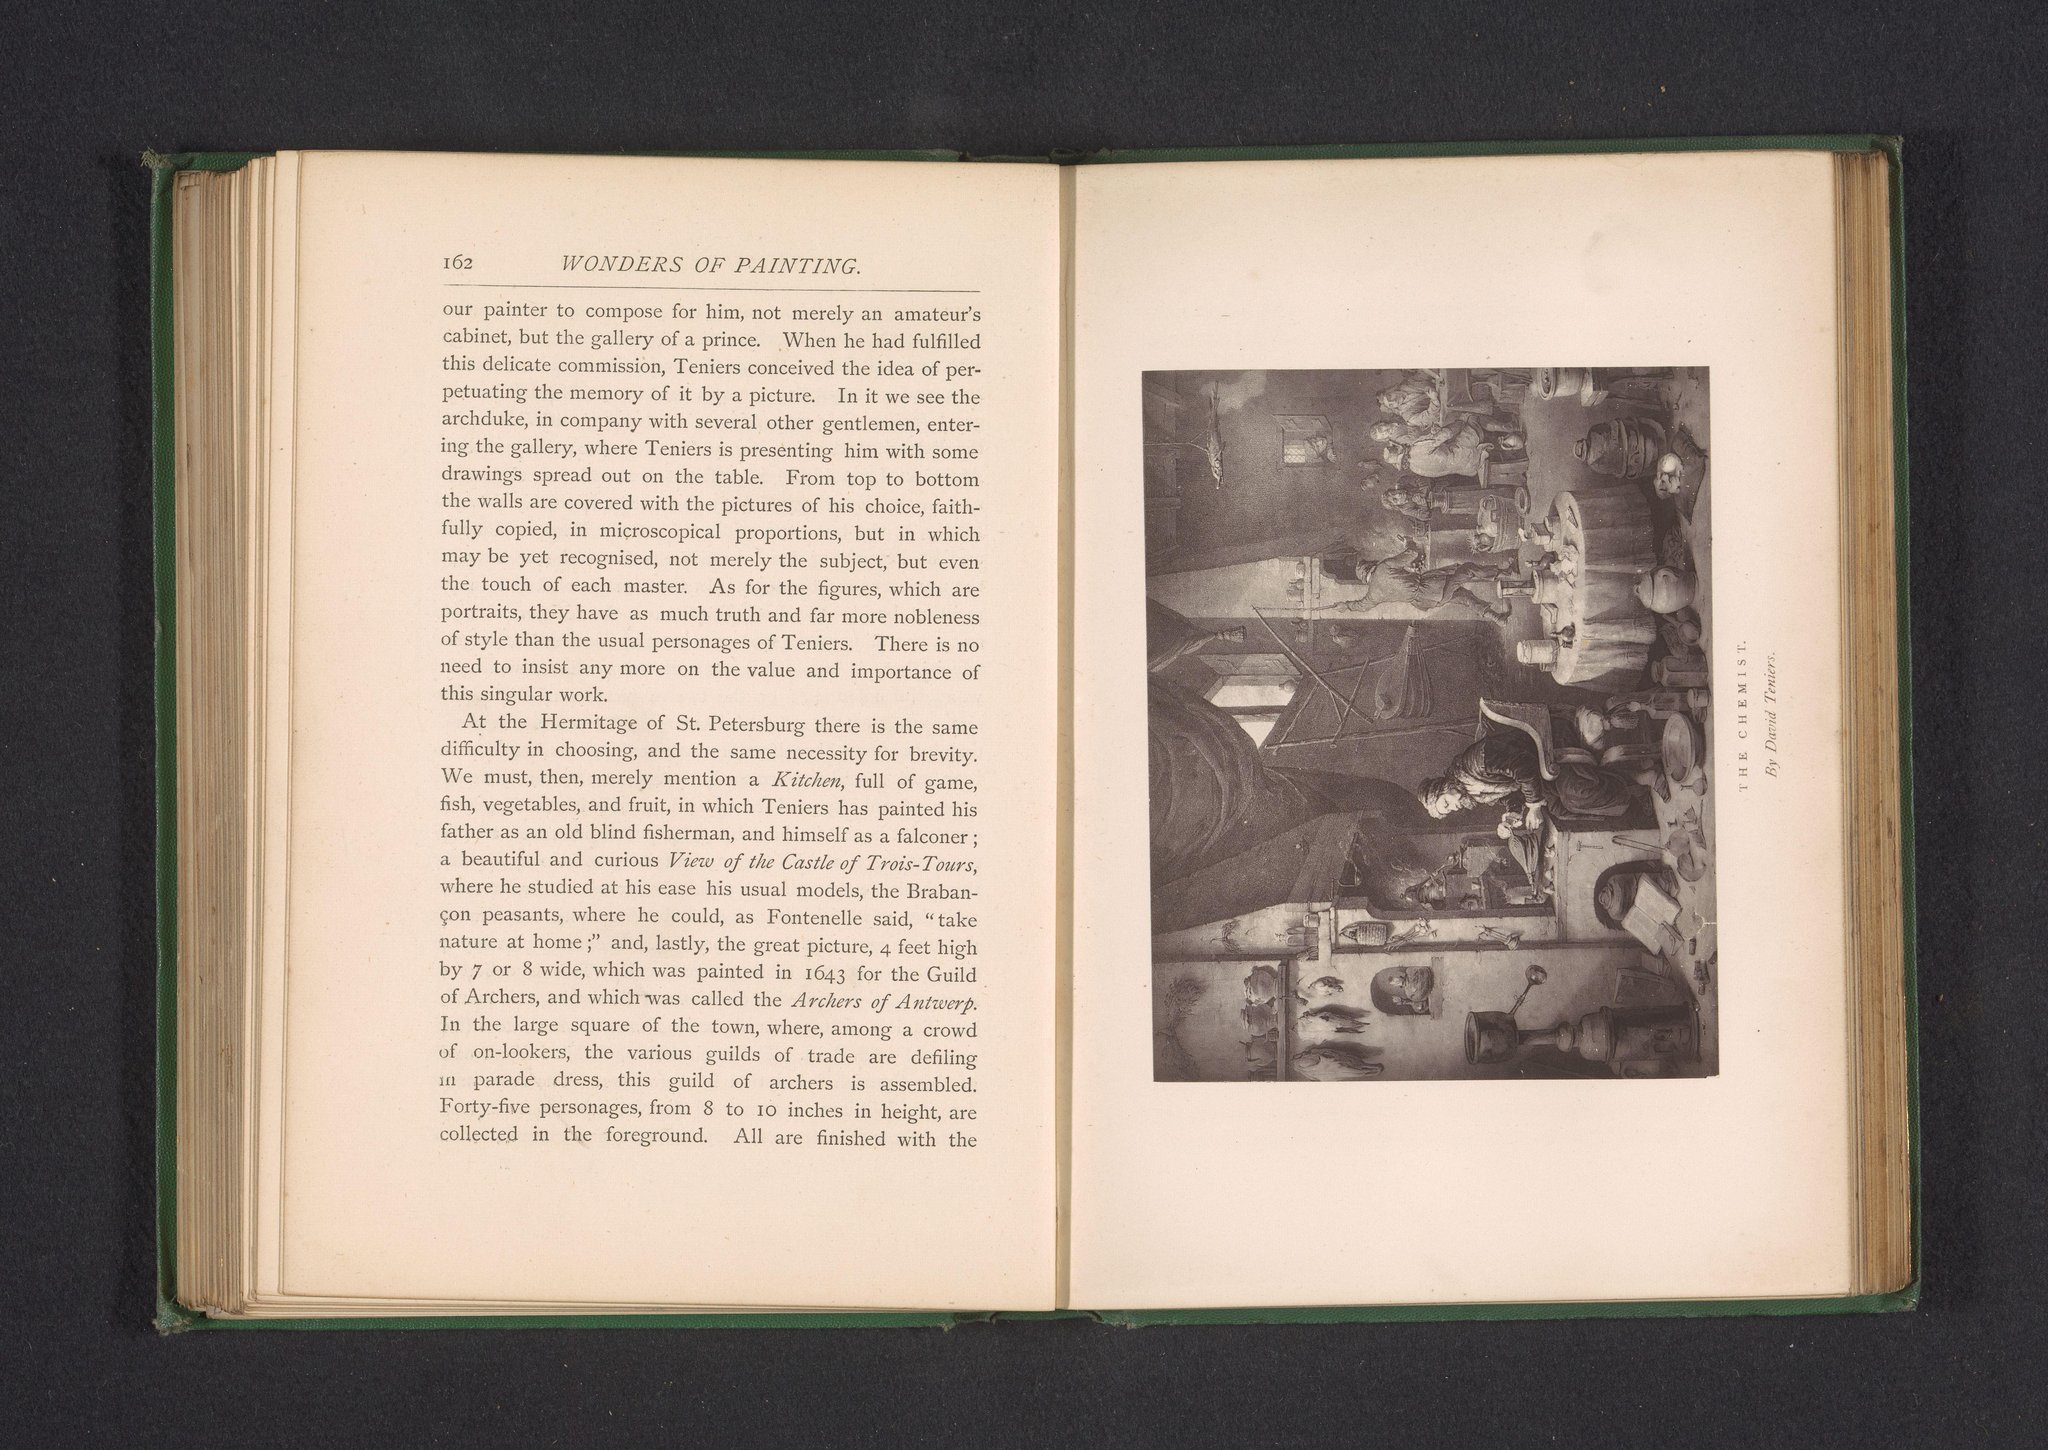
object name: page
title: The chemist. By David Teniers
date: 1861-1871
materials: paper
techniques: woodburytype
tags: alchemist at work